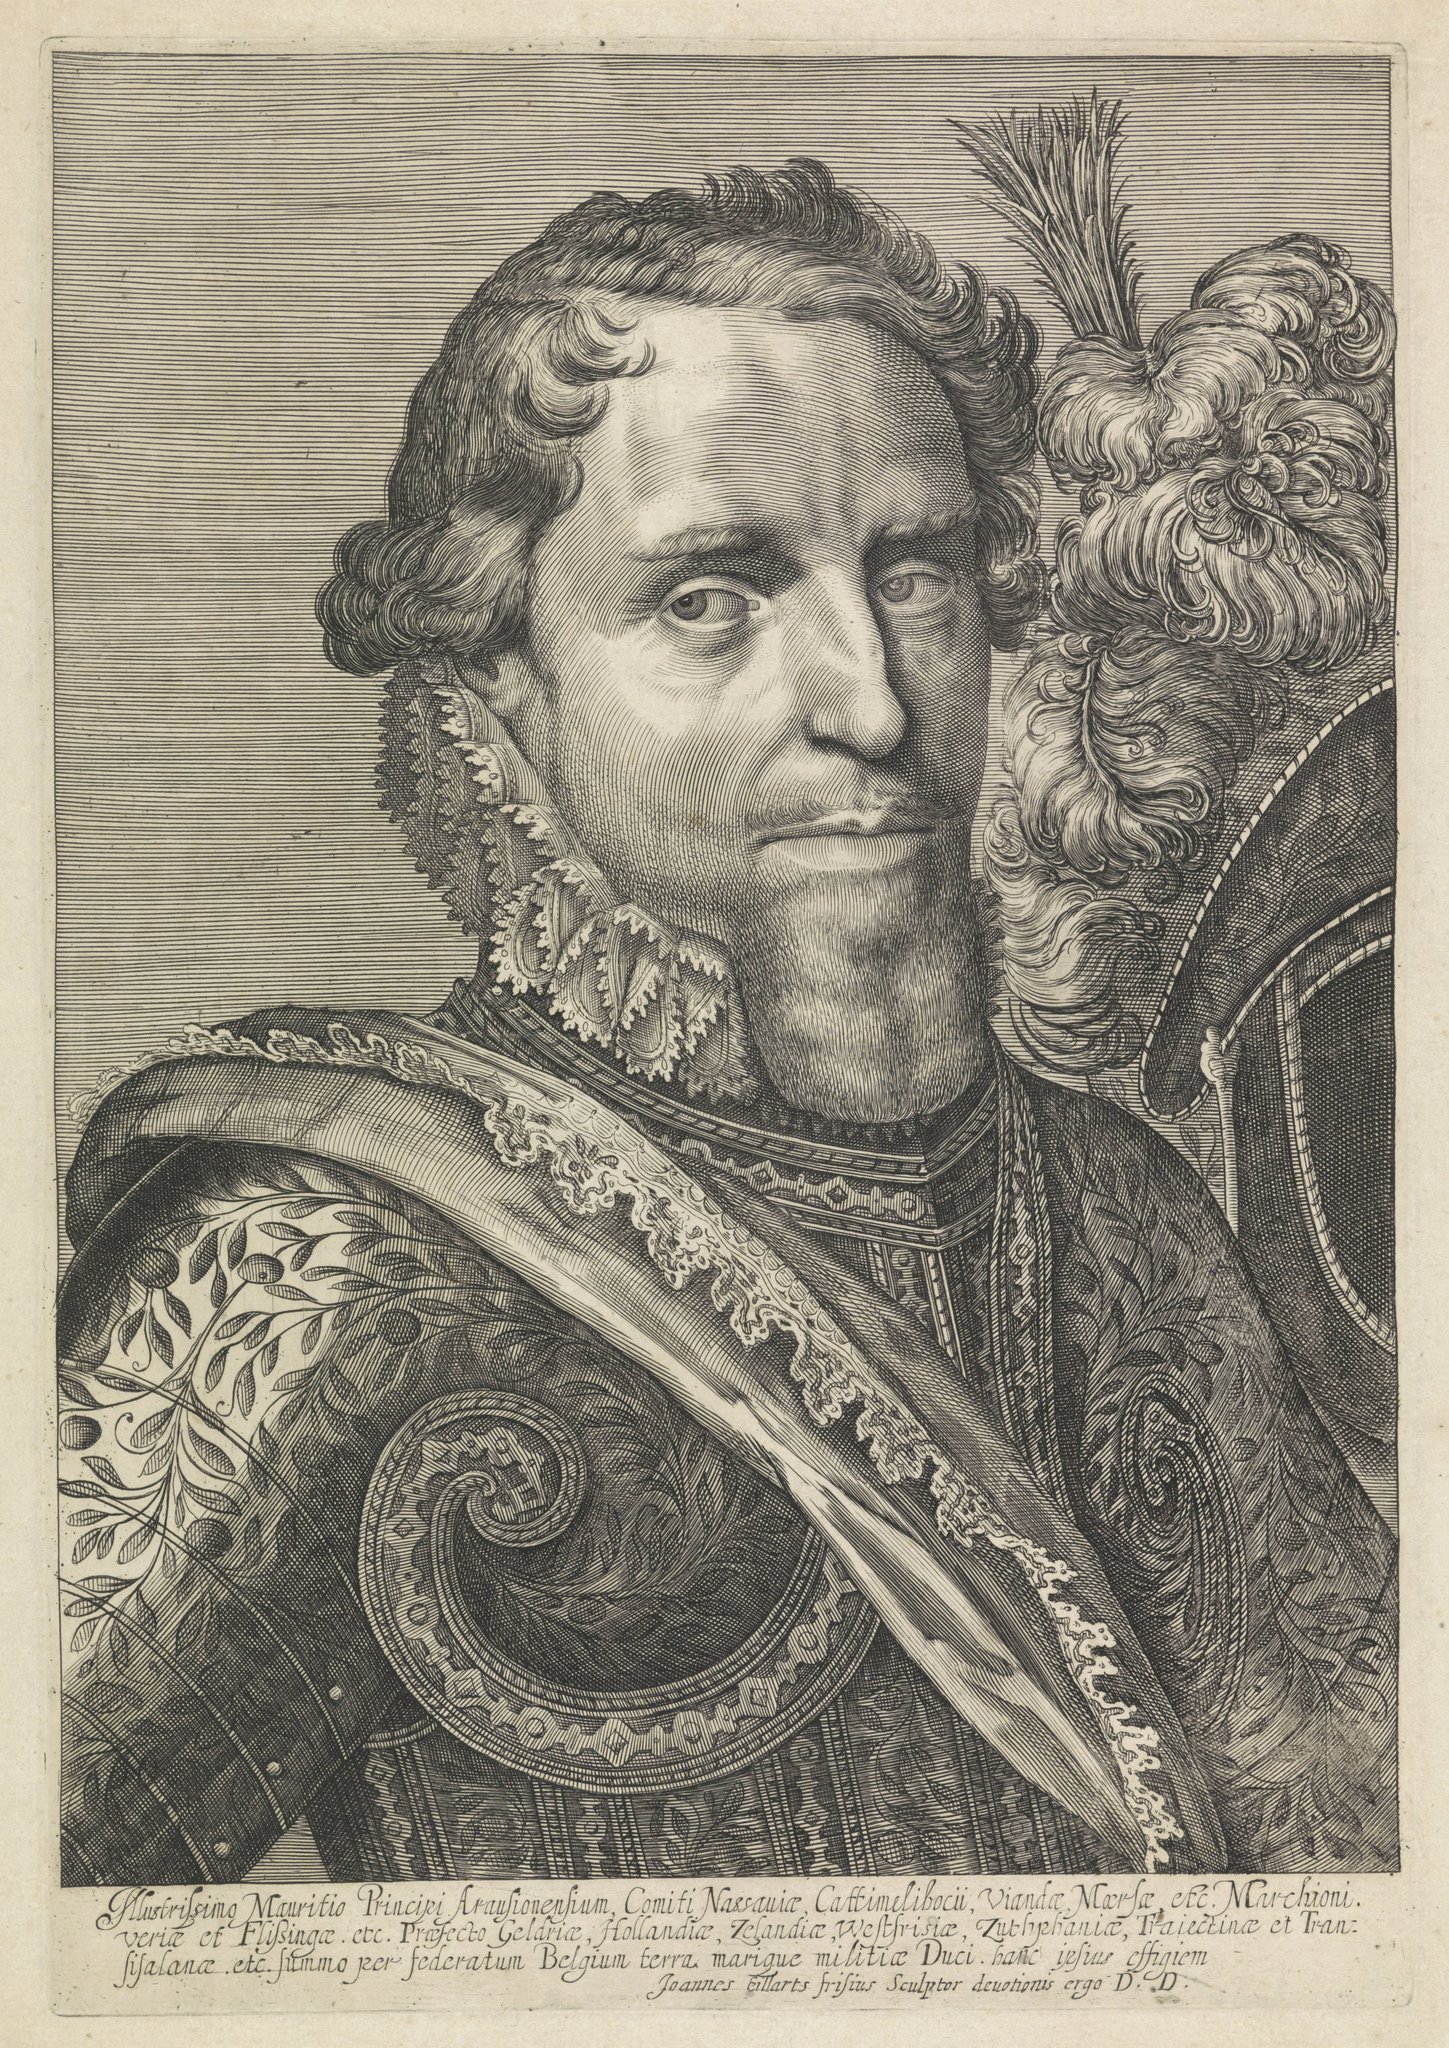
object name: print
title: Portret van Maurits, prins van Oranje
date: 1600-1650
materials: paper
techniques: engraving, etching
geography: low countries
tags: the hague, maurice (prince of orange)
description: De hier vermelde titel verwijst naar de hoogst verkregen titel van de geportretteerde, niet per se naar de titel die de geportretteerde op deze voorstelling draagt.